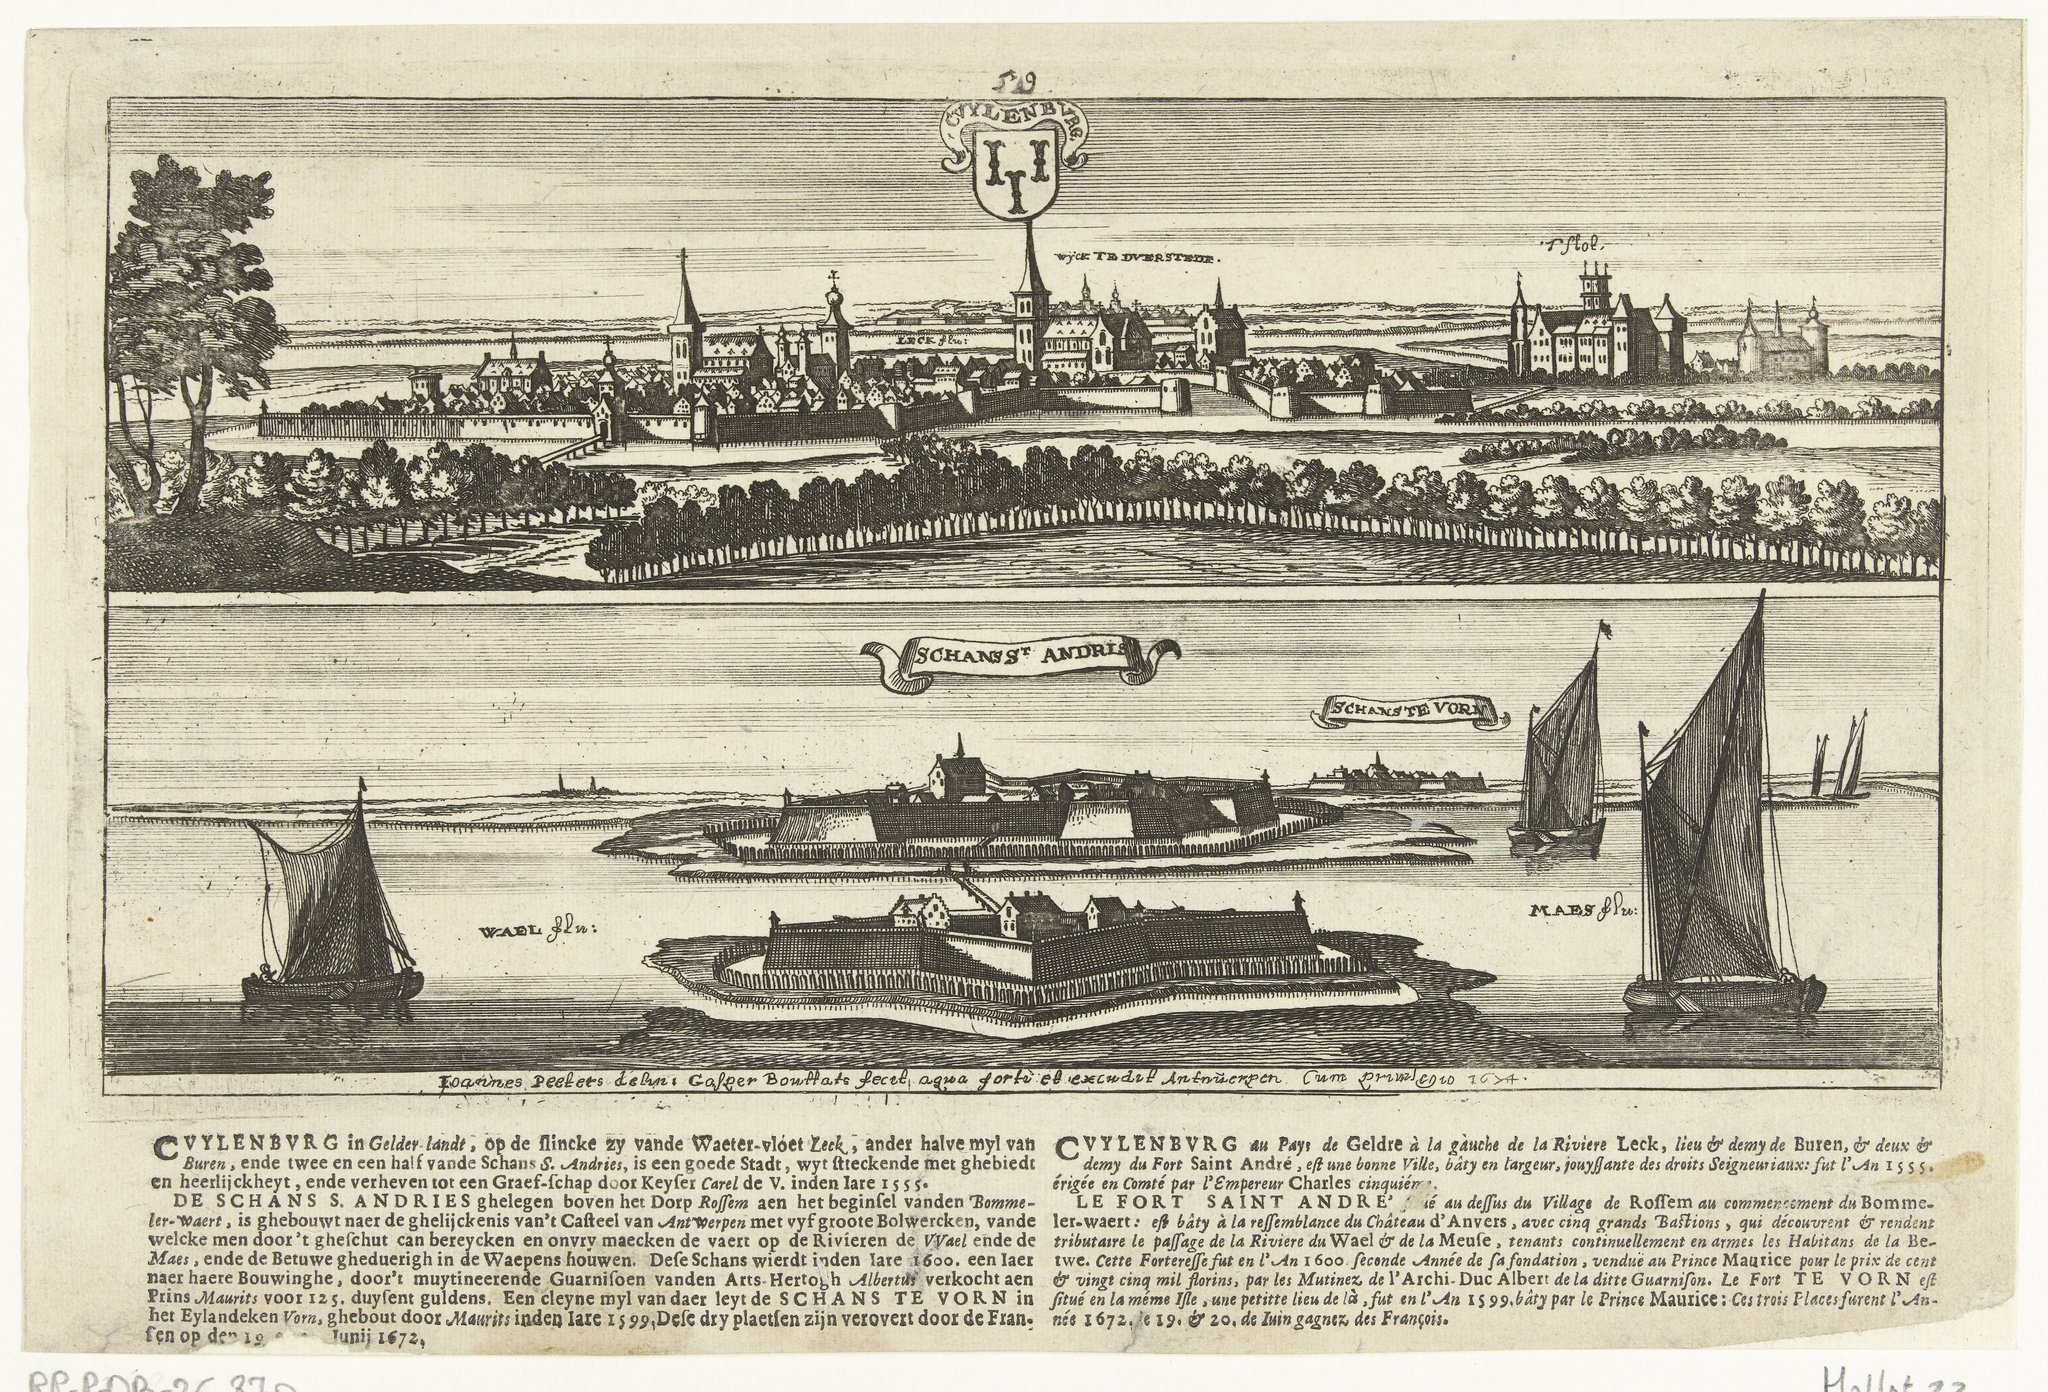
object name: print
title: Gezicht op Culemborg en Schans Sint-Andries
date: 1674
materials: paper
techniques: etching, letterpress printing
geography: antwerp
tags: prospect of city, town panorama, silhouette of city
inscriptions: collector's mark: Lugt 2228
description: Gezicht op de stad Culemborg en het fort Schans Sint Andries. Bij het gezicht op Culemborg zijn enkele gebouwen en wijken aangeduid. Het gezicht op Fort Sint Andries varen boten over Maas en Waal. Boven de stadsgezichten cartouches met de naam van de stad (en voor Culemborg het wapenschild). De prent heeft een Nederlands en Frans onderschrift.